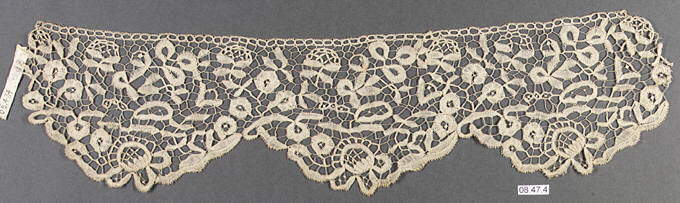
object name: edging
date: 1801-1833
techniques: lace